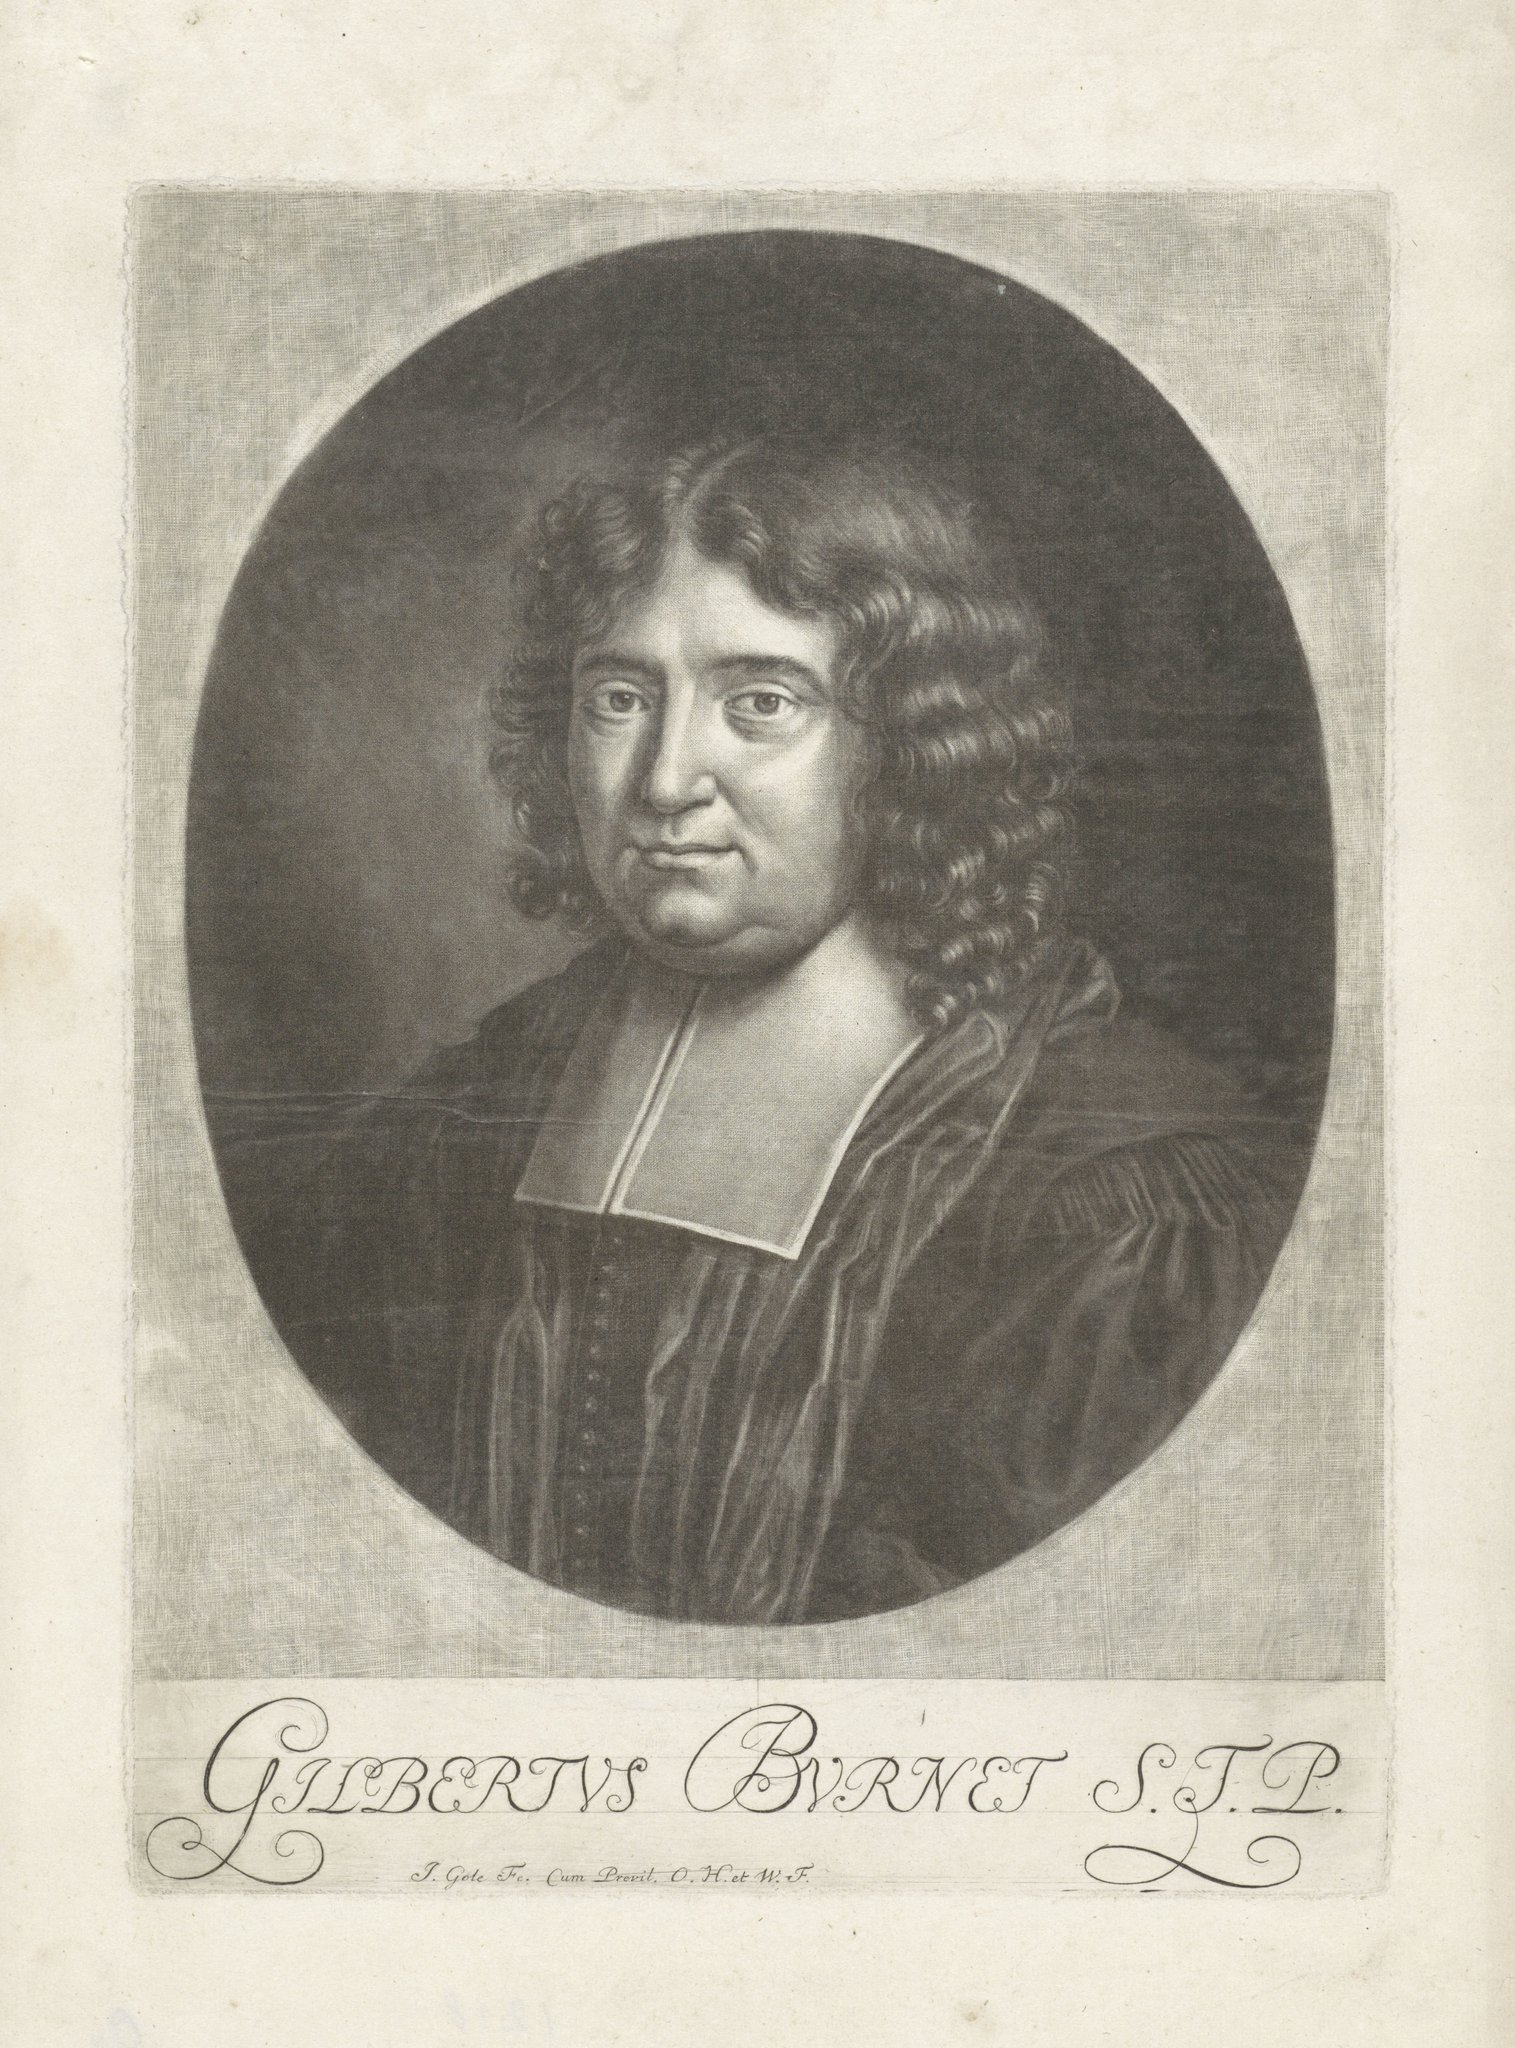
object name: print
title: Portret van Gilbert Burnet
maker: jacob gole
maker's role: print maker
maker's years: 1660-1724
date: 1670-1724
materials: paper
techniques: mezzotint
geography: amsterdam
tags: edinburgh, historicus, gilbert burnet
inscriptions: collector's mark: Lugt 2228